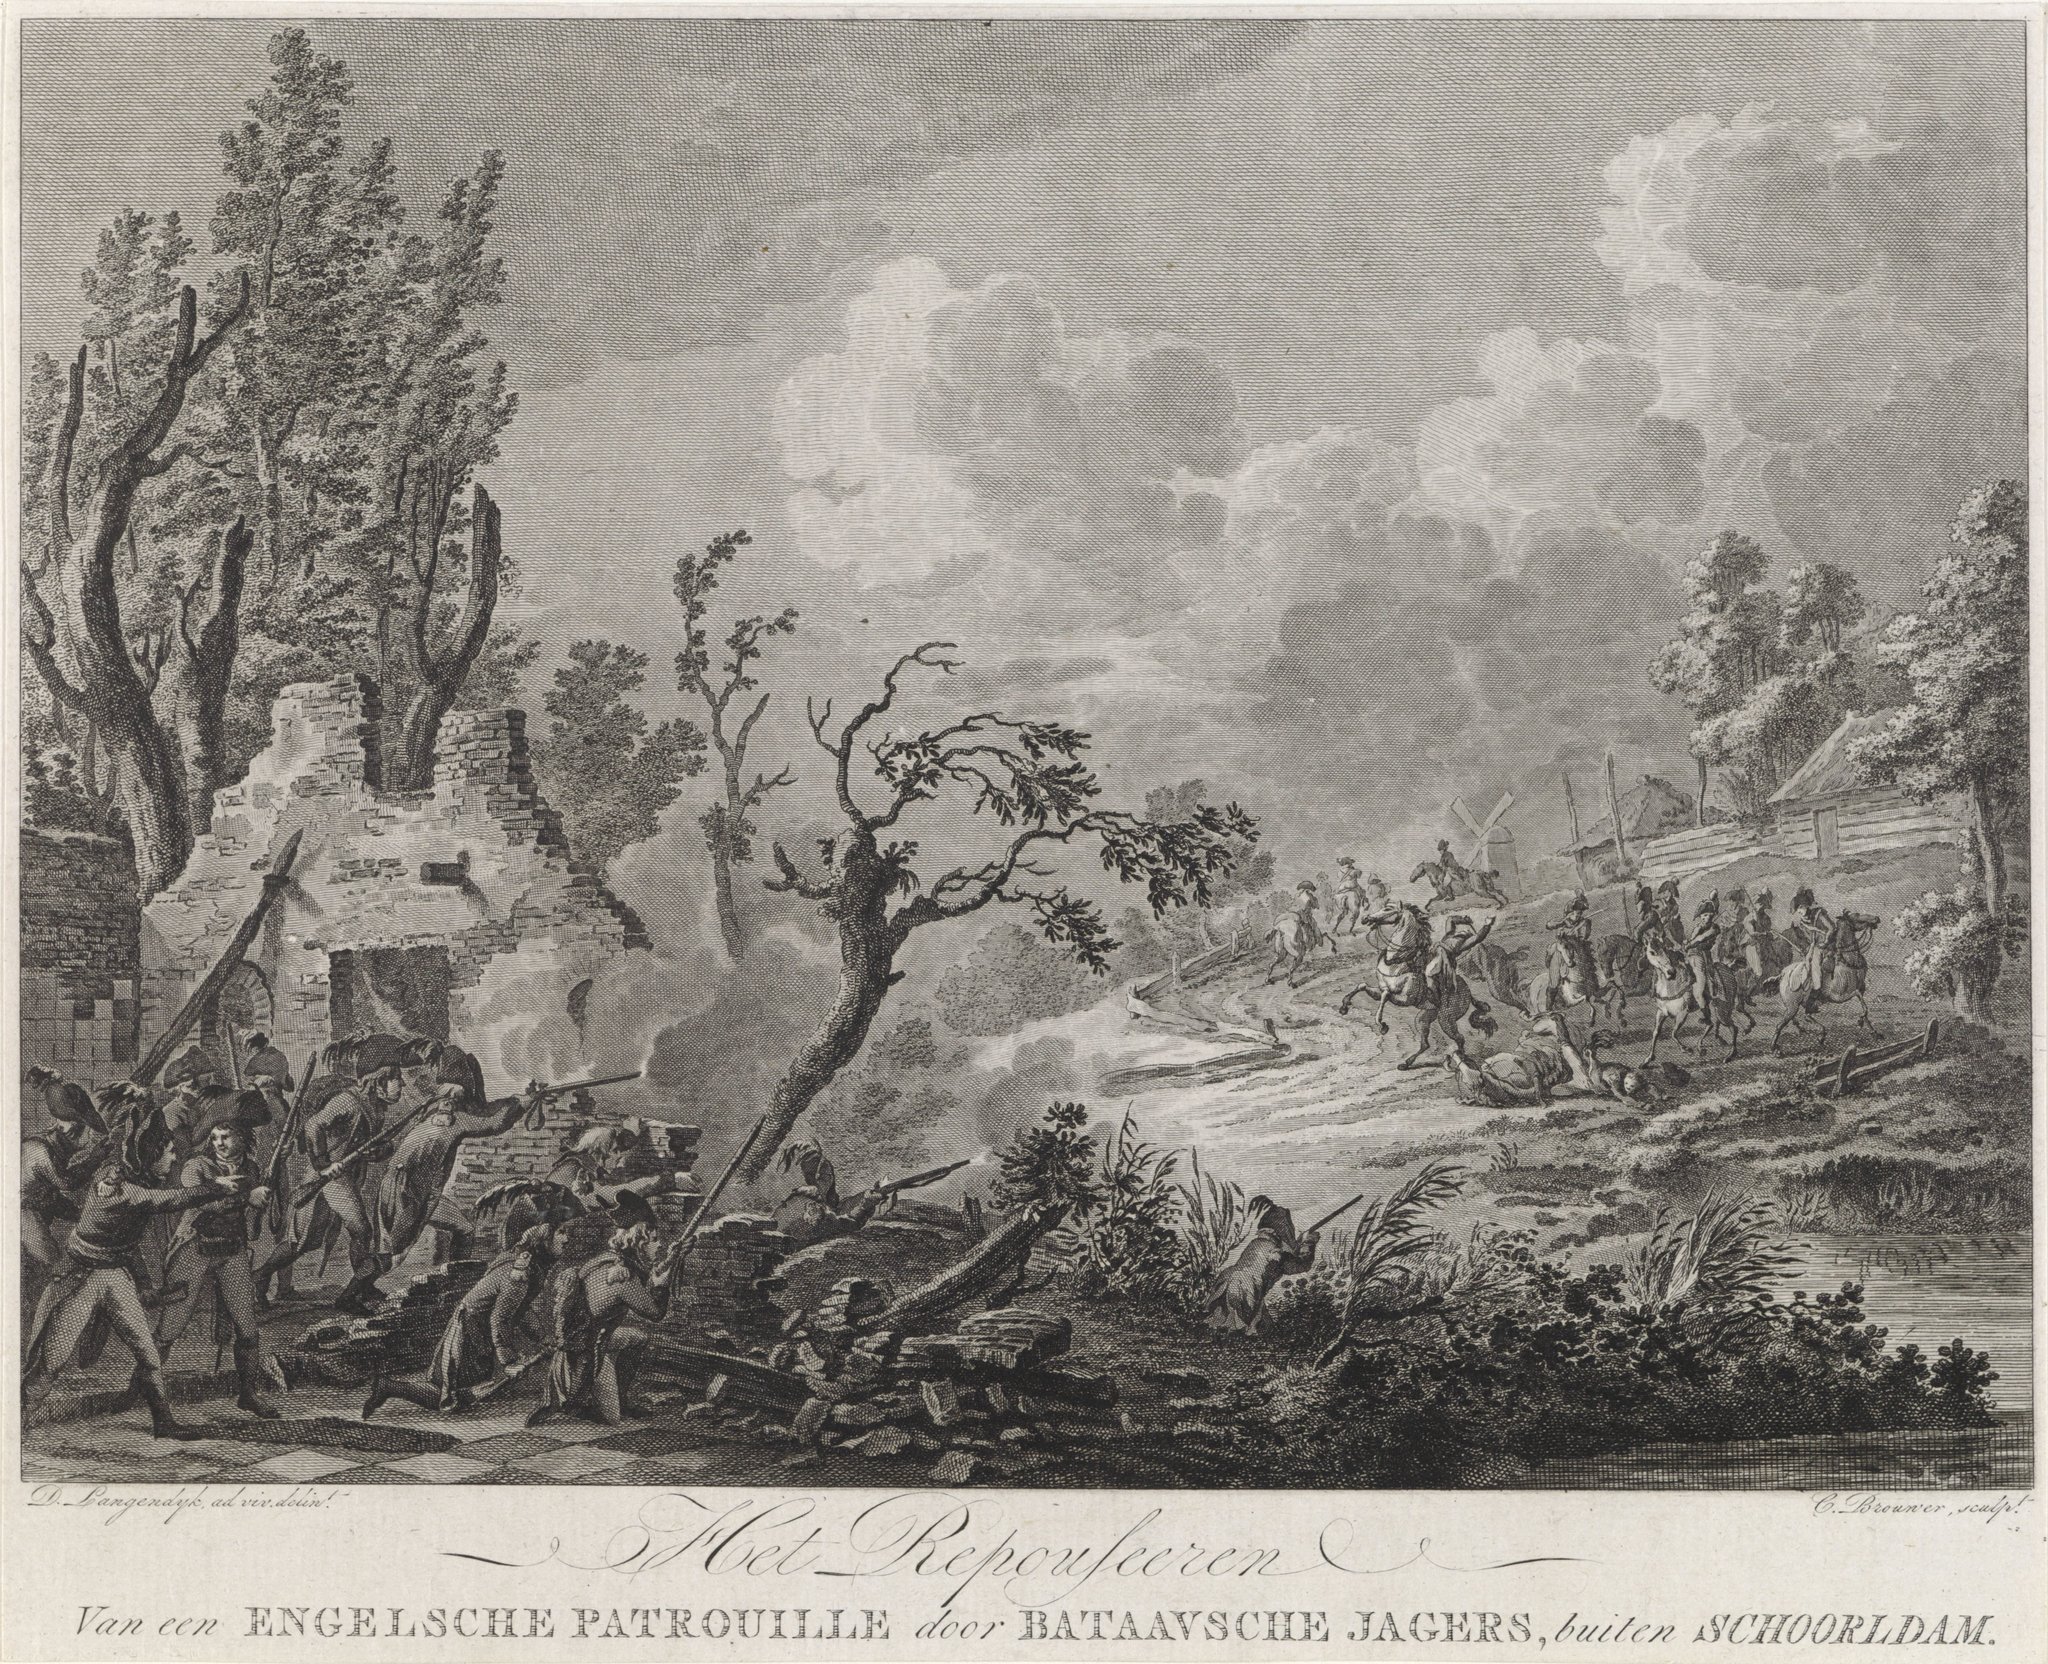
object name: print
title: Gevechten bij Schoorldam, 1799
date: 1800-1802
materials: paper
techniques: engraving, etching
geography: netherlands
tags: battle (+ land forces)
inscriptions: collector's mark: Lugt 2228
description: Een Britse patrouille wordt door Bataafse jagers onder vuur genomen, bij Schoorldam, 1799. Vanachter de ruïnes van een gebouw schieten de soldaten op de Britse ruiters.